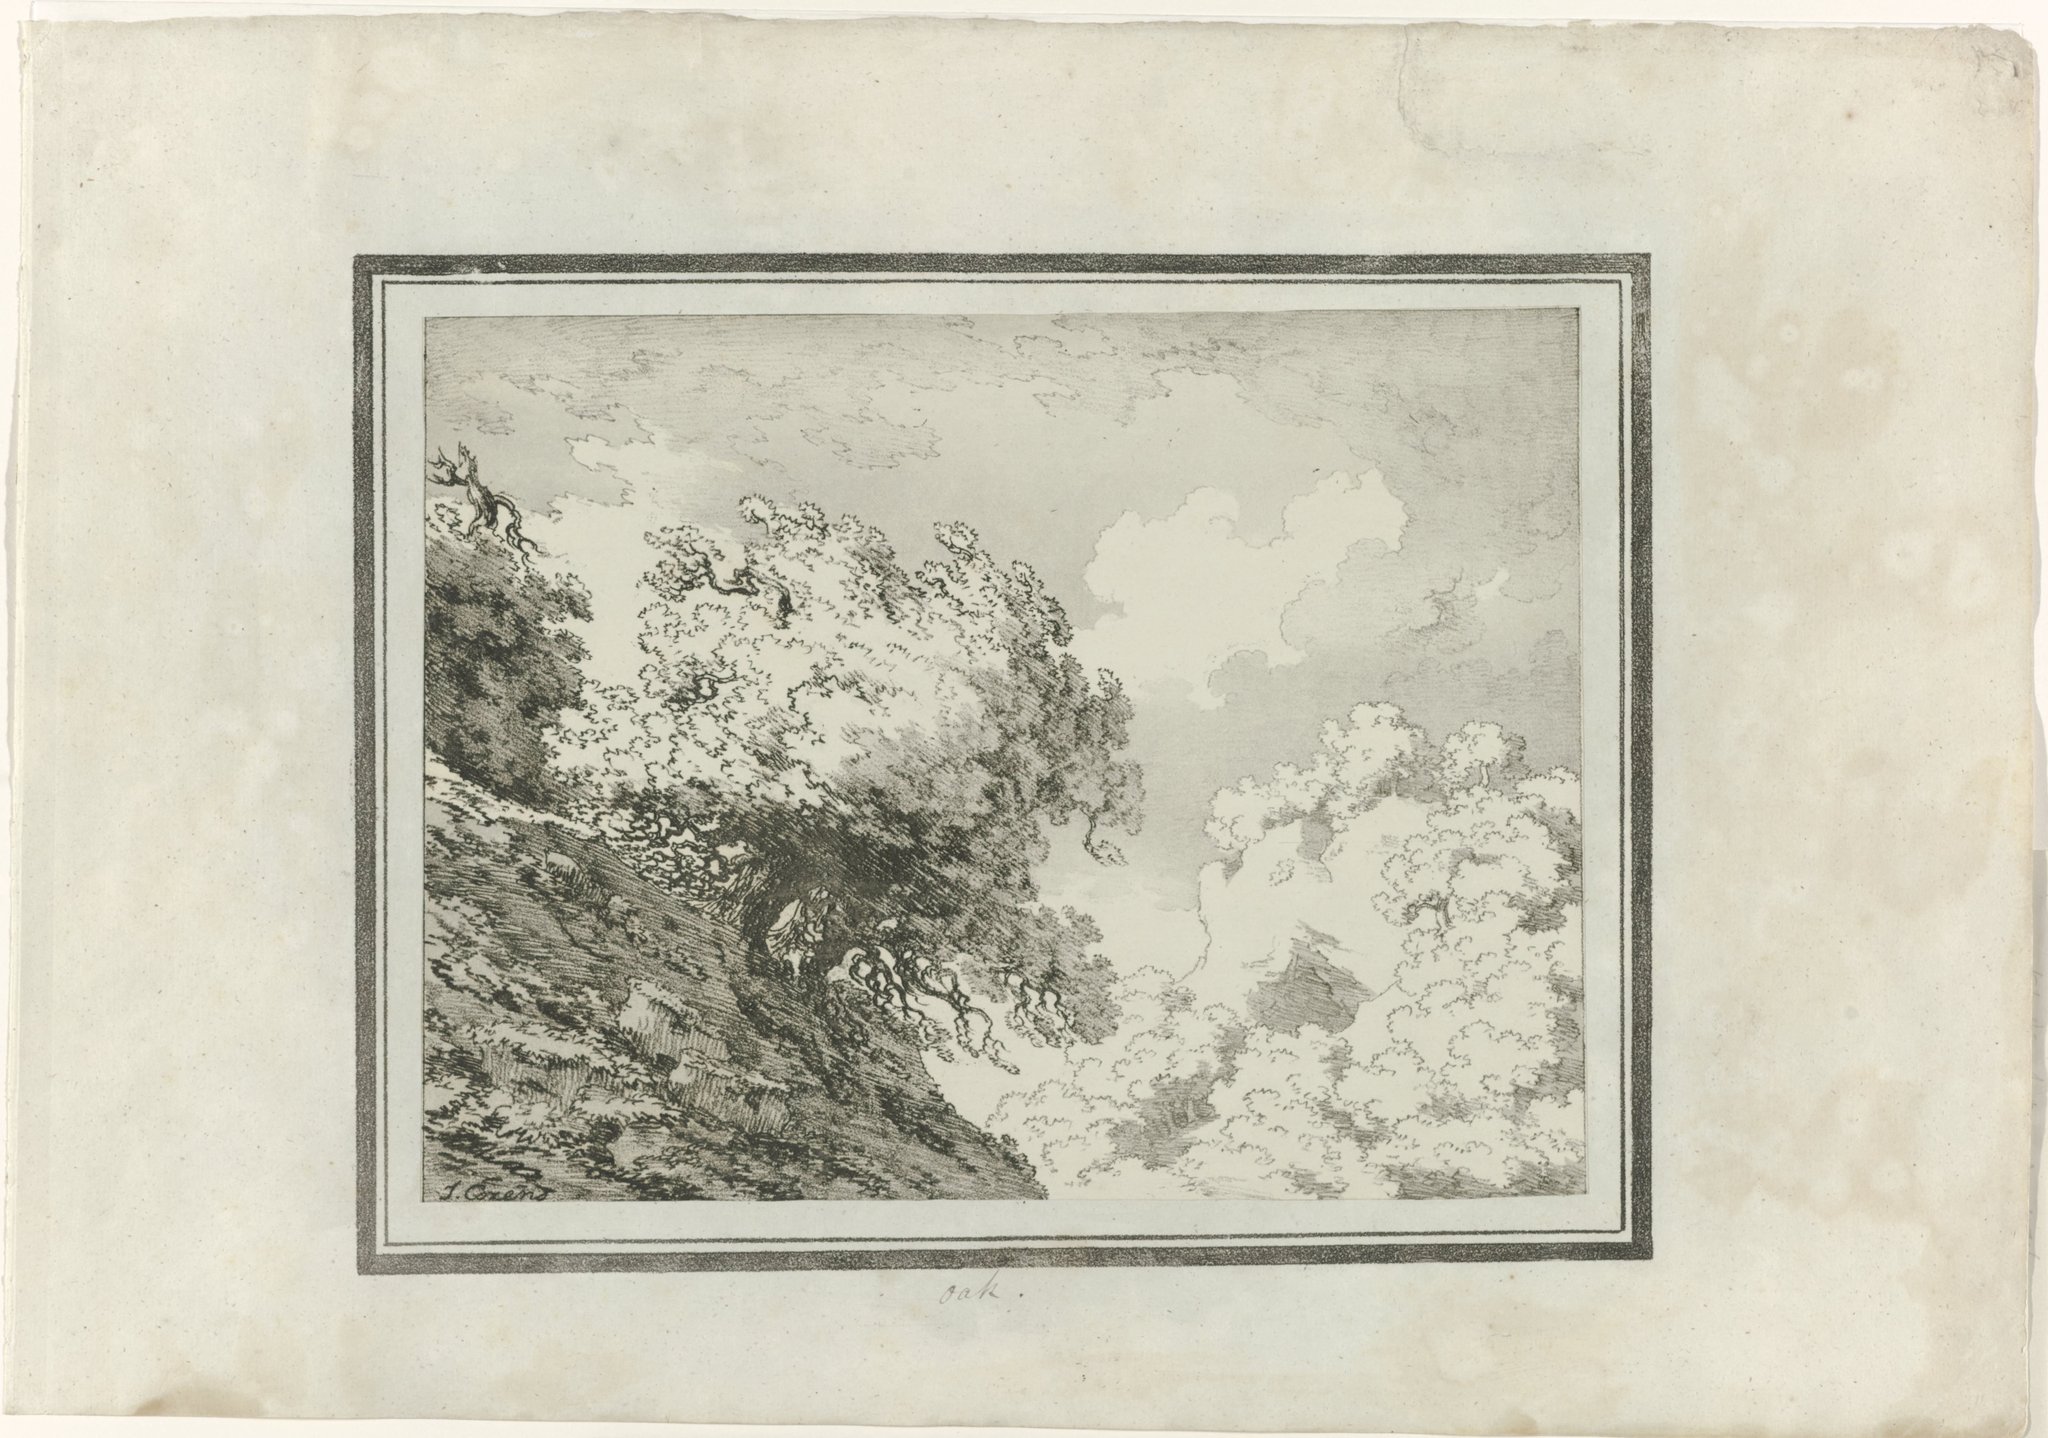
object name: print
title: Oak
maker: john robert cozens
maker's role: draughtsman, print maker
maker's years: 1752-1797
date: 1789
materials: paper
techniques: aquatint, soft ground etching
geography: london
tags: trees: oak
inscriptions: title: ‘Oak.’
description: Prent uit album in cassette met veertien studies in vernis mou en aquatint van verschillende soorten bomen.